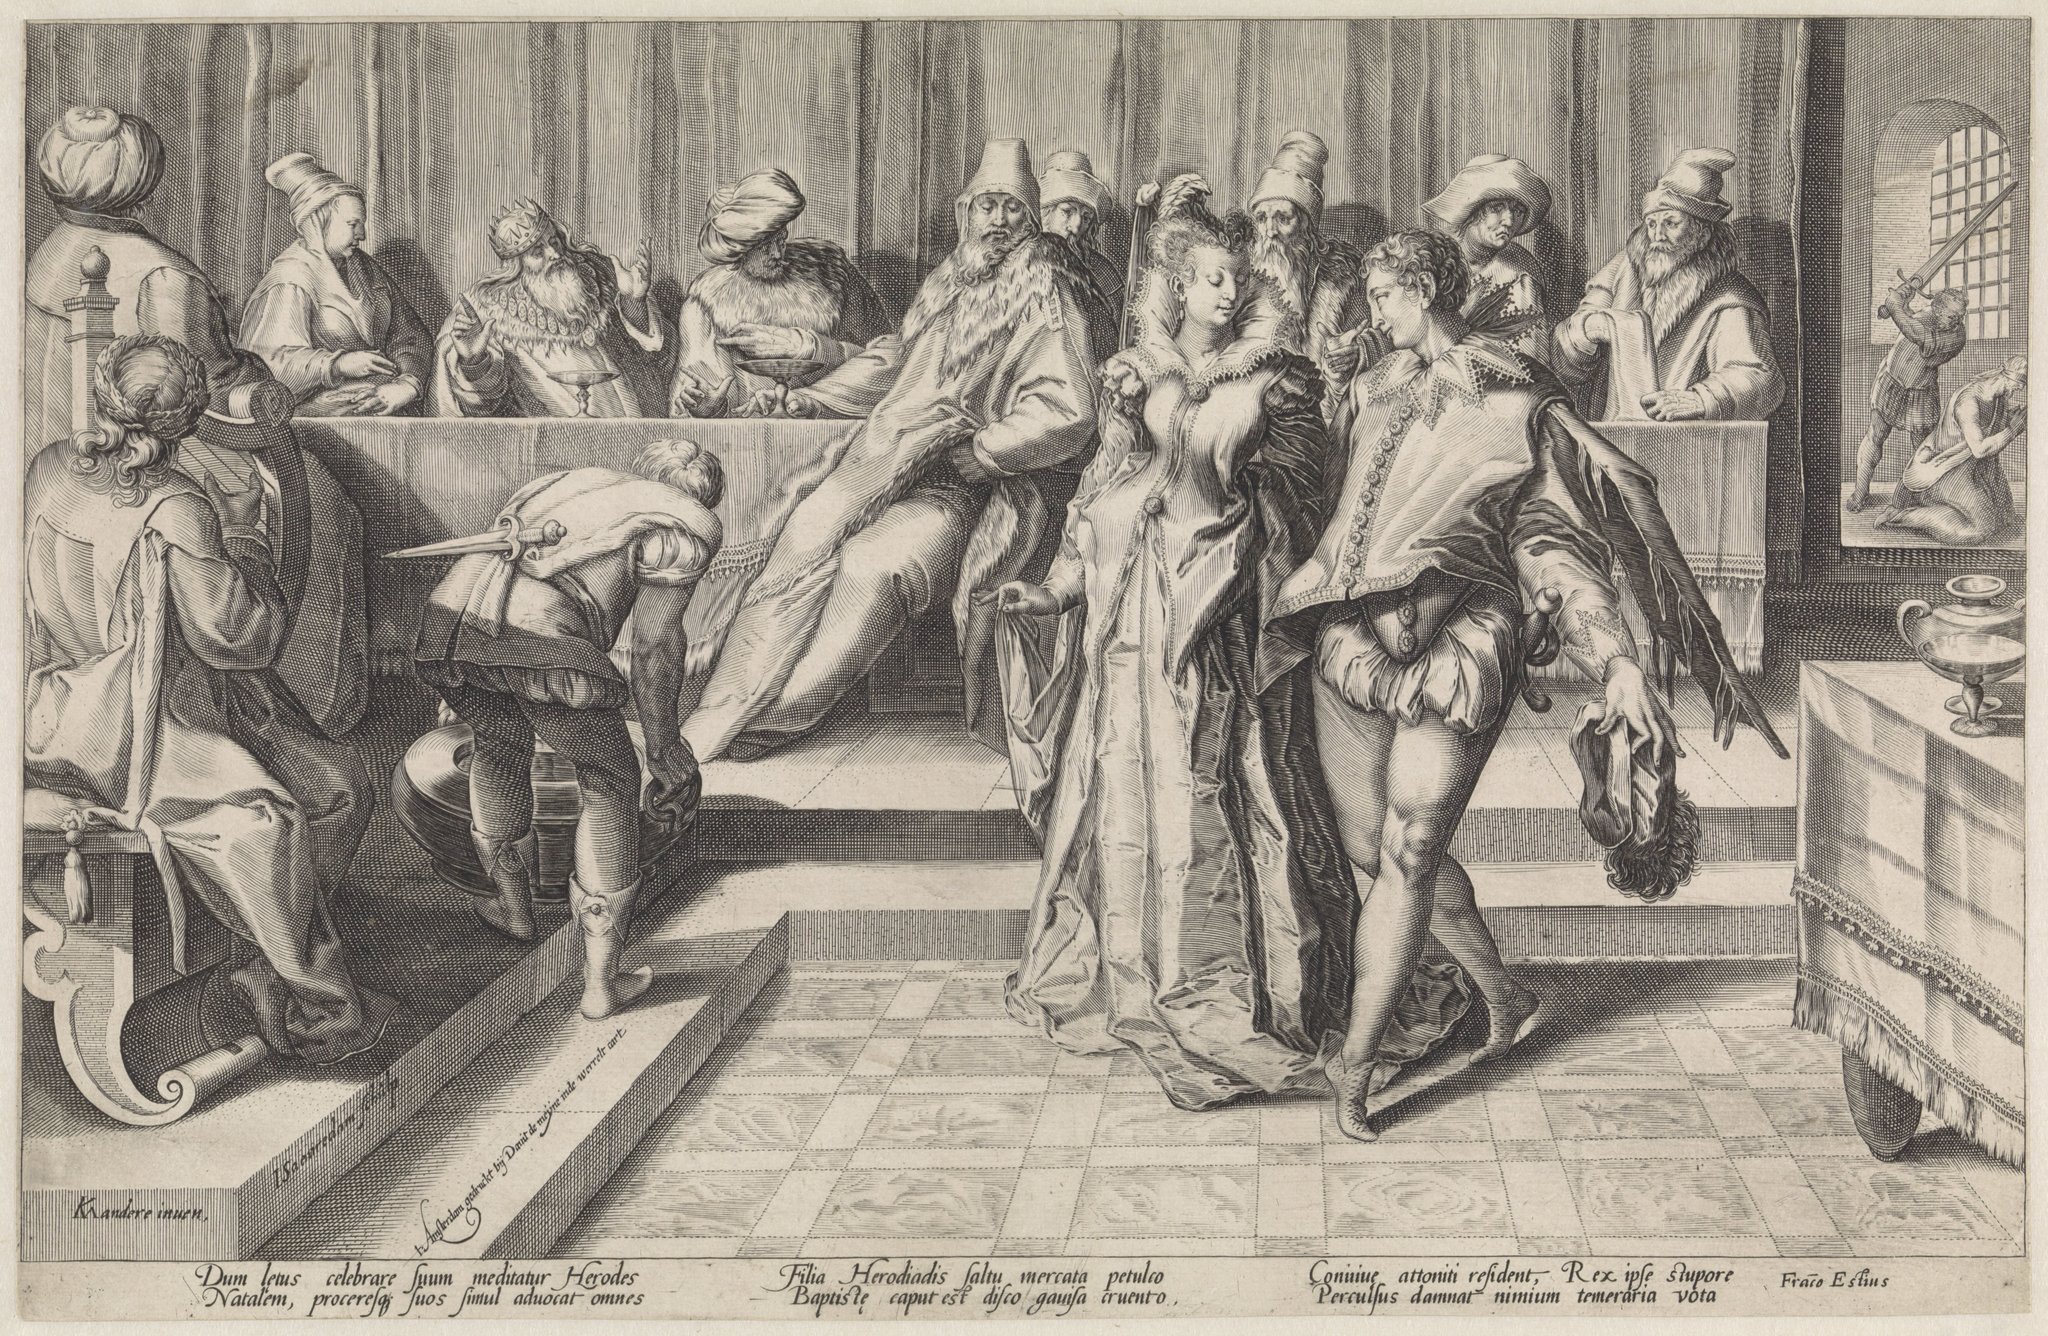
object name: print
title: Salome bij het banket van Herodes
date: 1589-1607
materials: paper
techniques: engraving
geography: amsterdam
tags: salome dancing during the banquet of herod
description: Salome en een jonge man dansen(?) voor een lange tafel, waaraan verschillende personen zitten, onder wie Herodes. Links houdt een man een vat vast. Rechtsachter knielt de geblinddoekte Johannes de Doper voor een man met een opgeheven zwaard. Onder de voorstelling een zesregelige, Latijnse tekst met een toelichting op de scène.